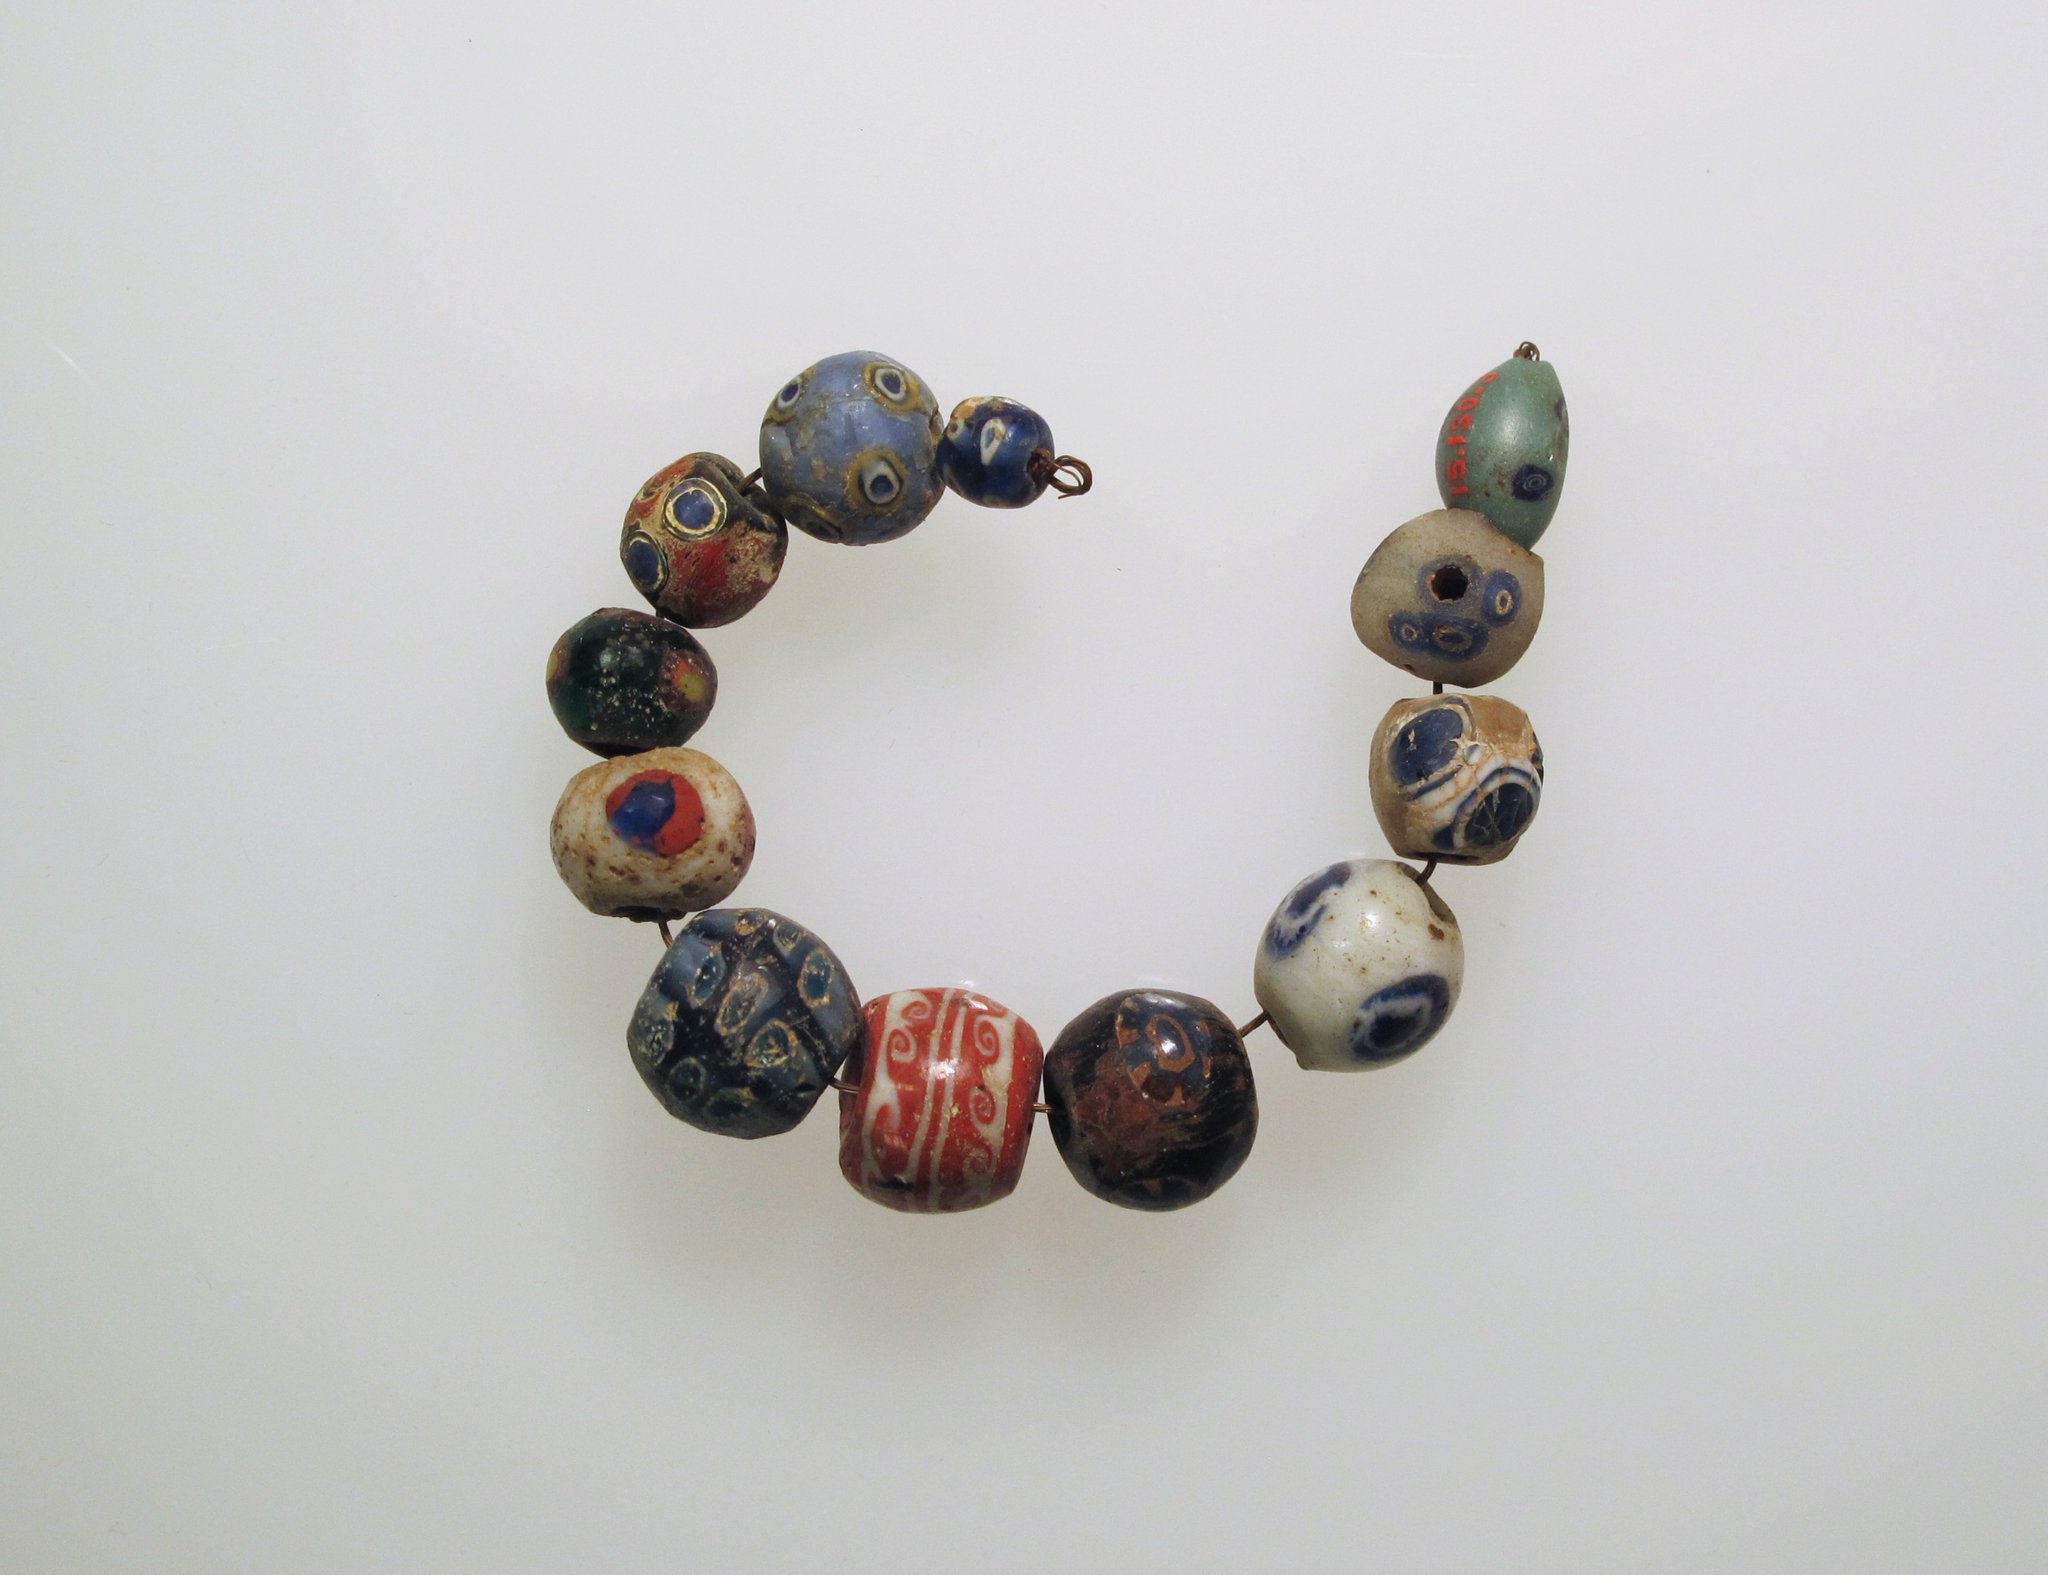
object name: bead, twelve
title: Glass mosaic beads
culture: roman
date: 1-100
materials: glass